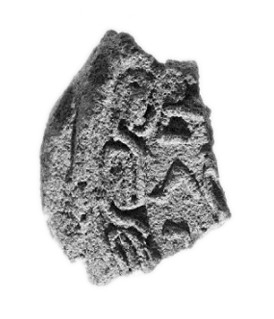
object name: sealing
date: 1981-1640 BCE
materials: mud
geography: egypt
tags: hieroglyphs